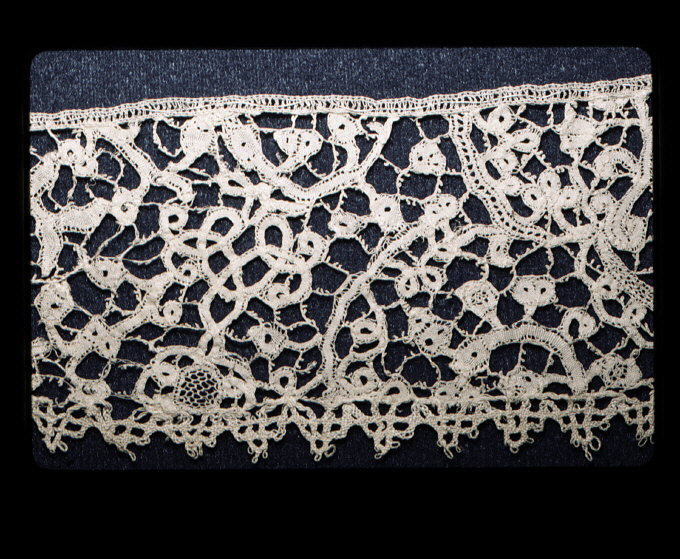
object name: fragment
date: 1667-1700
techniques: lace